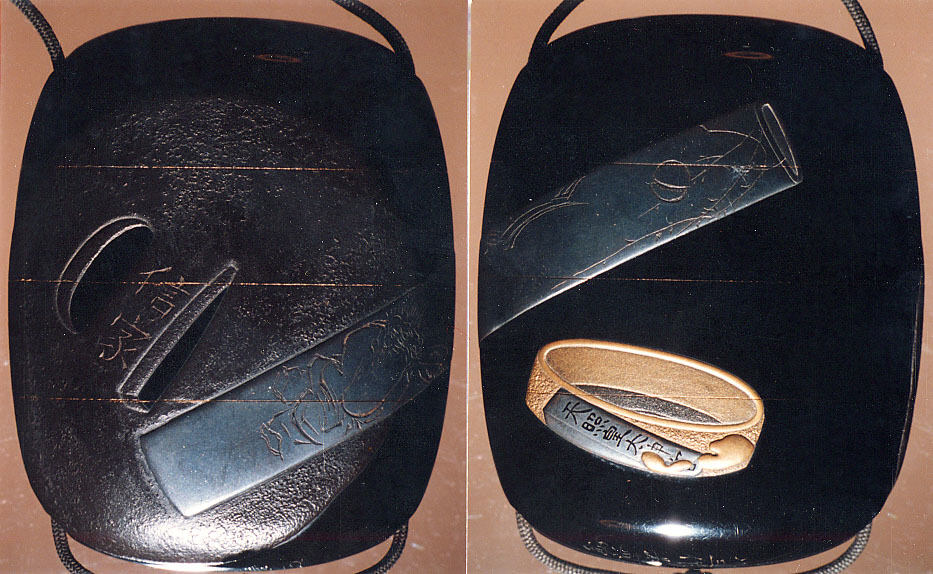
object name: inrō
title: Case (Inrō) with Design of Sword Fittings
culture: japanese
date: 1801-1900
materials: gold, lacquer, silver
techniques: fundame, hiramakie, incising, roiro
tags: swords